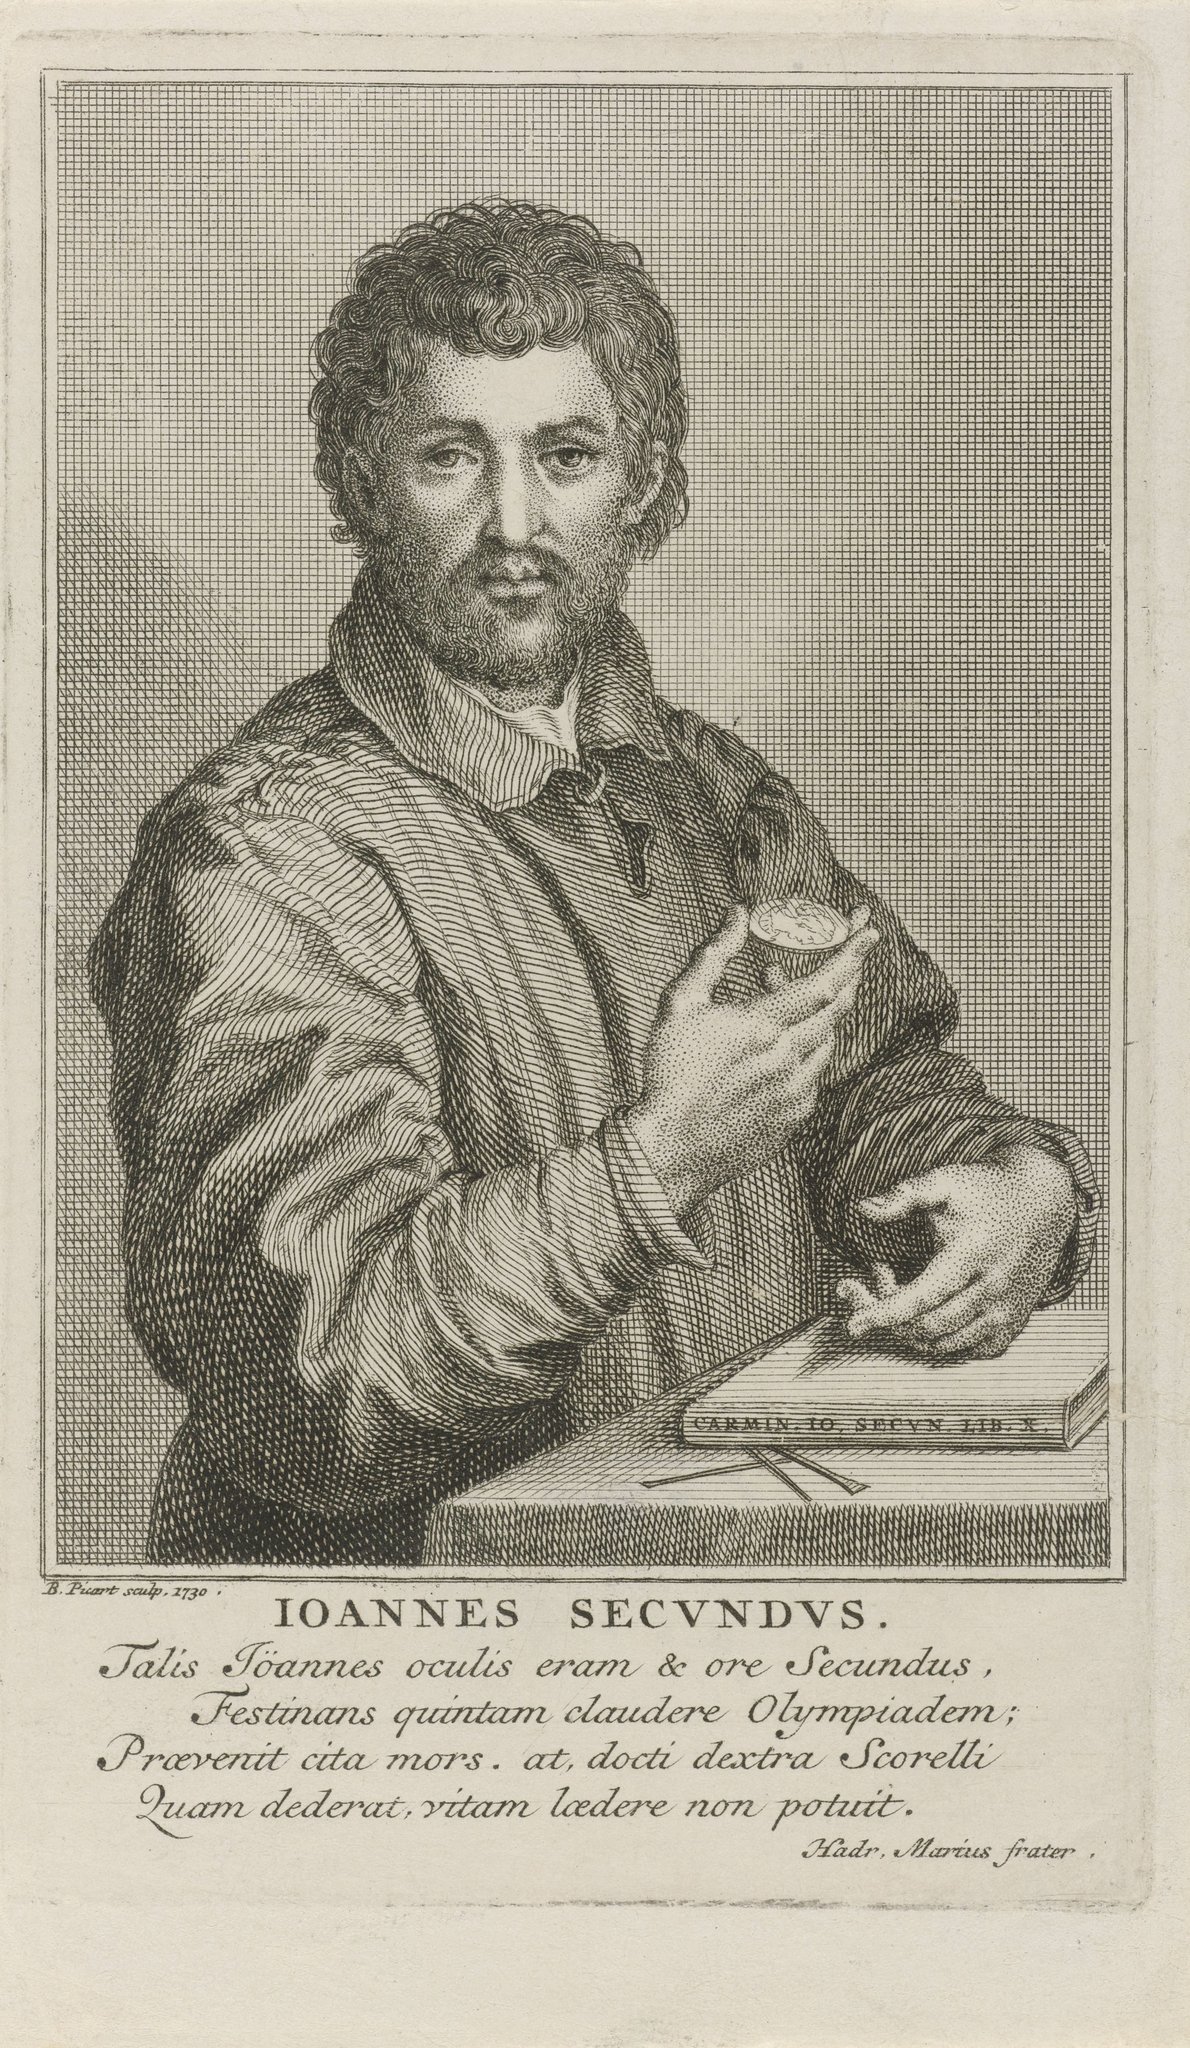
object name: print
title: Portret van Janus Secundus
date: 1730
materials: paper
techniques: engraving, etching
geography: amsterdam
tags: the hague, janus secundus, portrait of a writer, medal (considered as a piece of sculpture, regardless of its specific function)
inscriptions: collector's mark: Lugt 2228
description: Portret van de schrijver Janus Secundus. In zijn hand houdt hij een medaillon met het portret van Julia, zijn eerste grote liefde, over wie hij een liefdeselegie schreef. In de marge een vierregelig onderschrift in het Latijn.